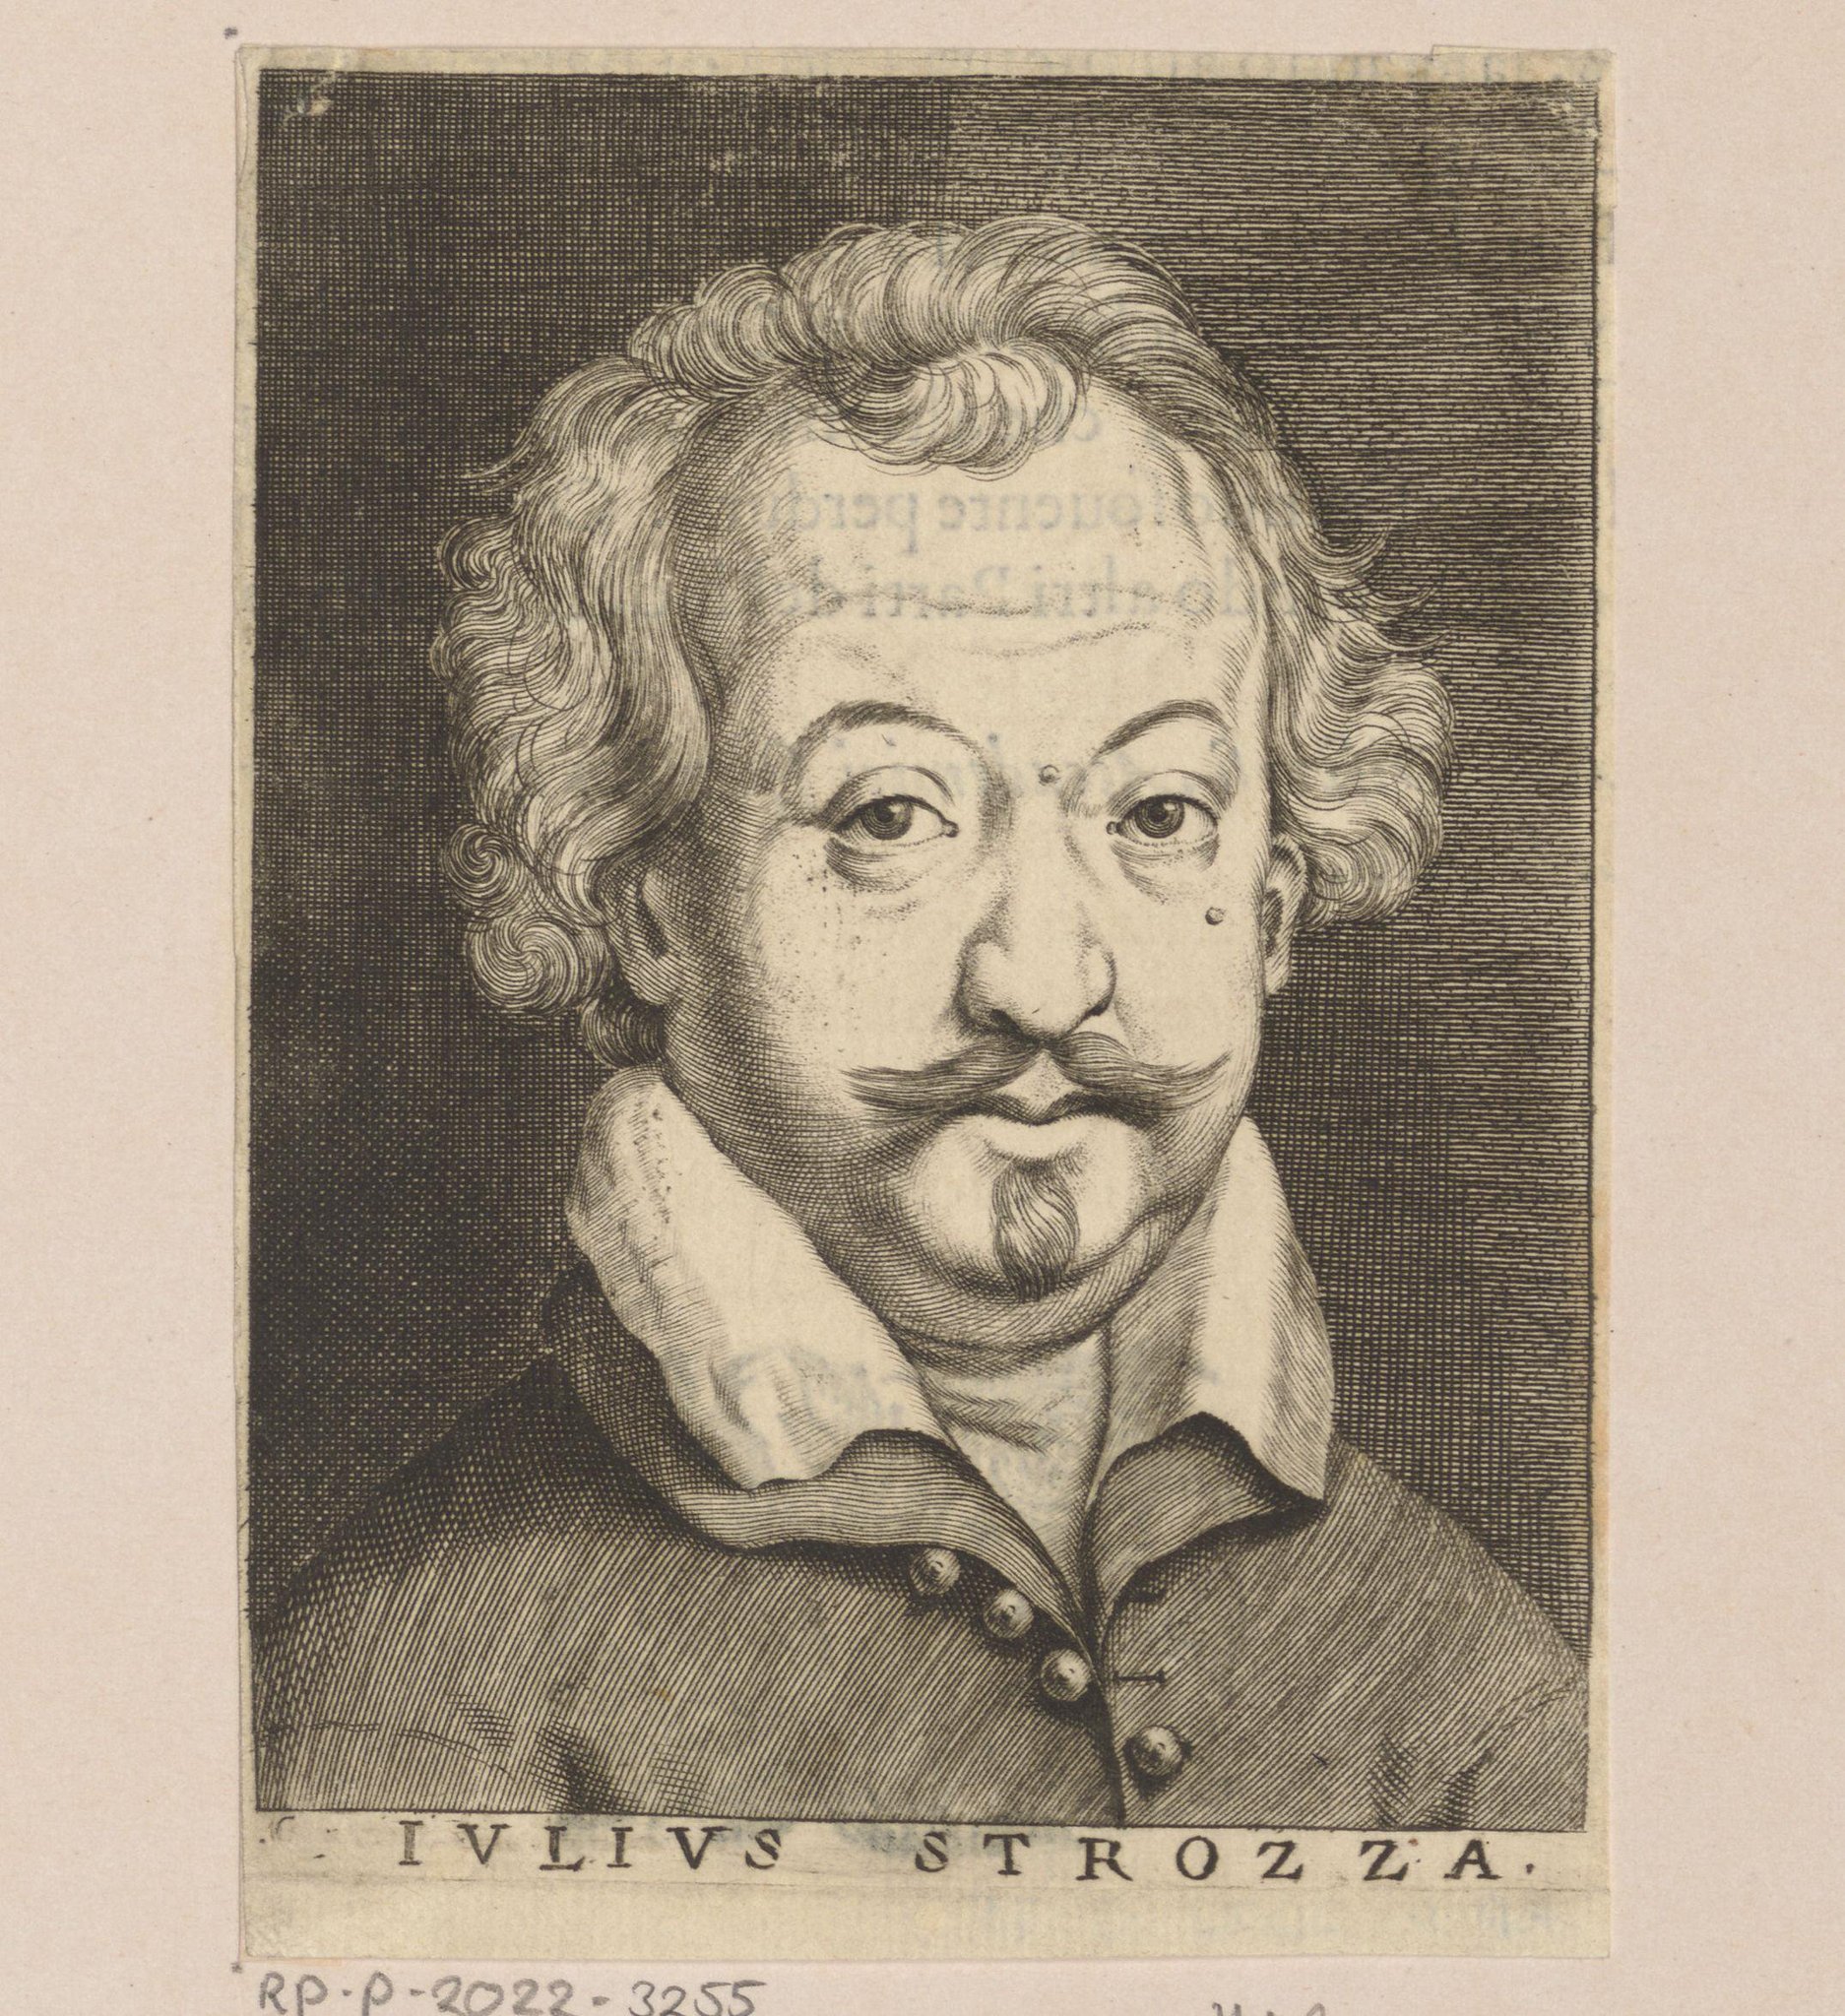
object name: book illustration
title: Portret van Giulio Strozzi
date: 1647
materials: paper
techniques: engraving, etching, letterpress printing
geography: venice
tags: venice, historical persons, portrait of a writer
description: Prent uit: Le glorie degli Incogniti o vero gli huomini illustri dell'accademia de signori Incogniti di Venetia. Venetië: Francesco Valvasense, 1647, p. 280.